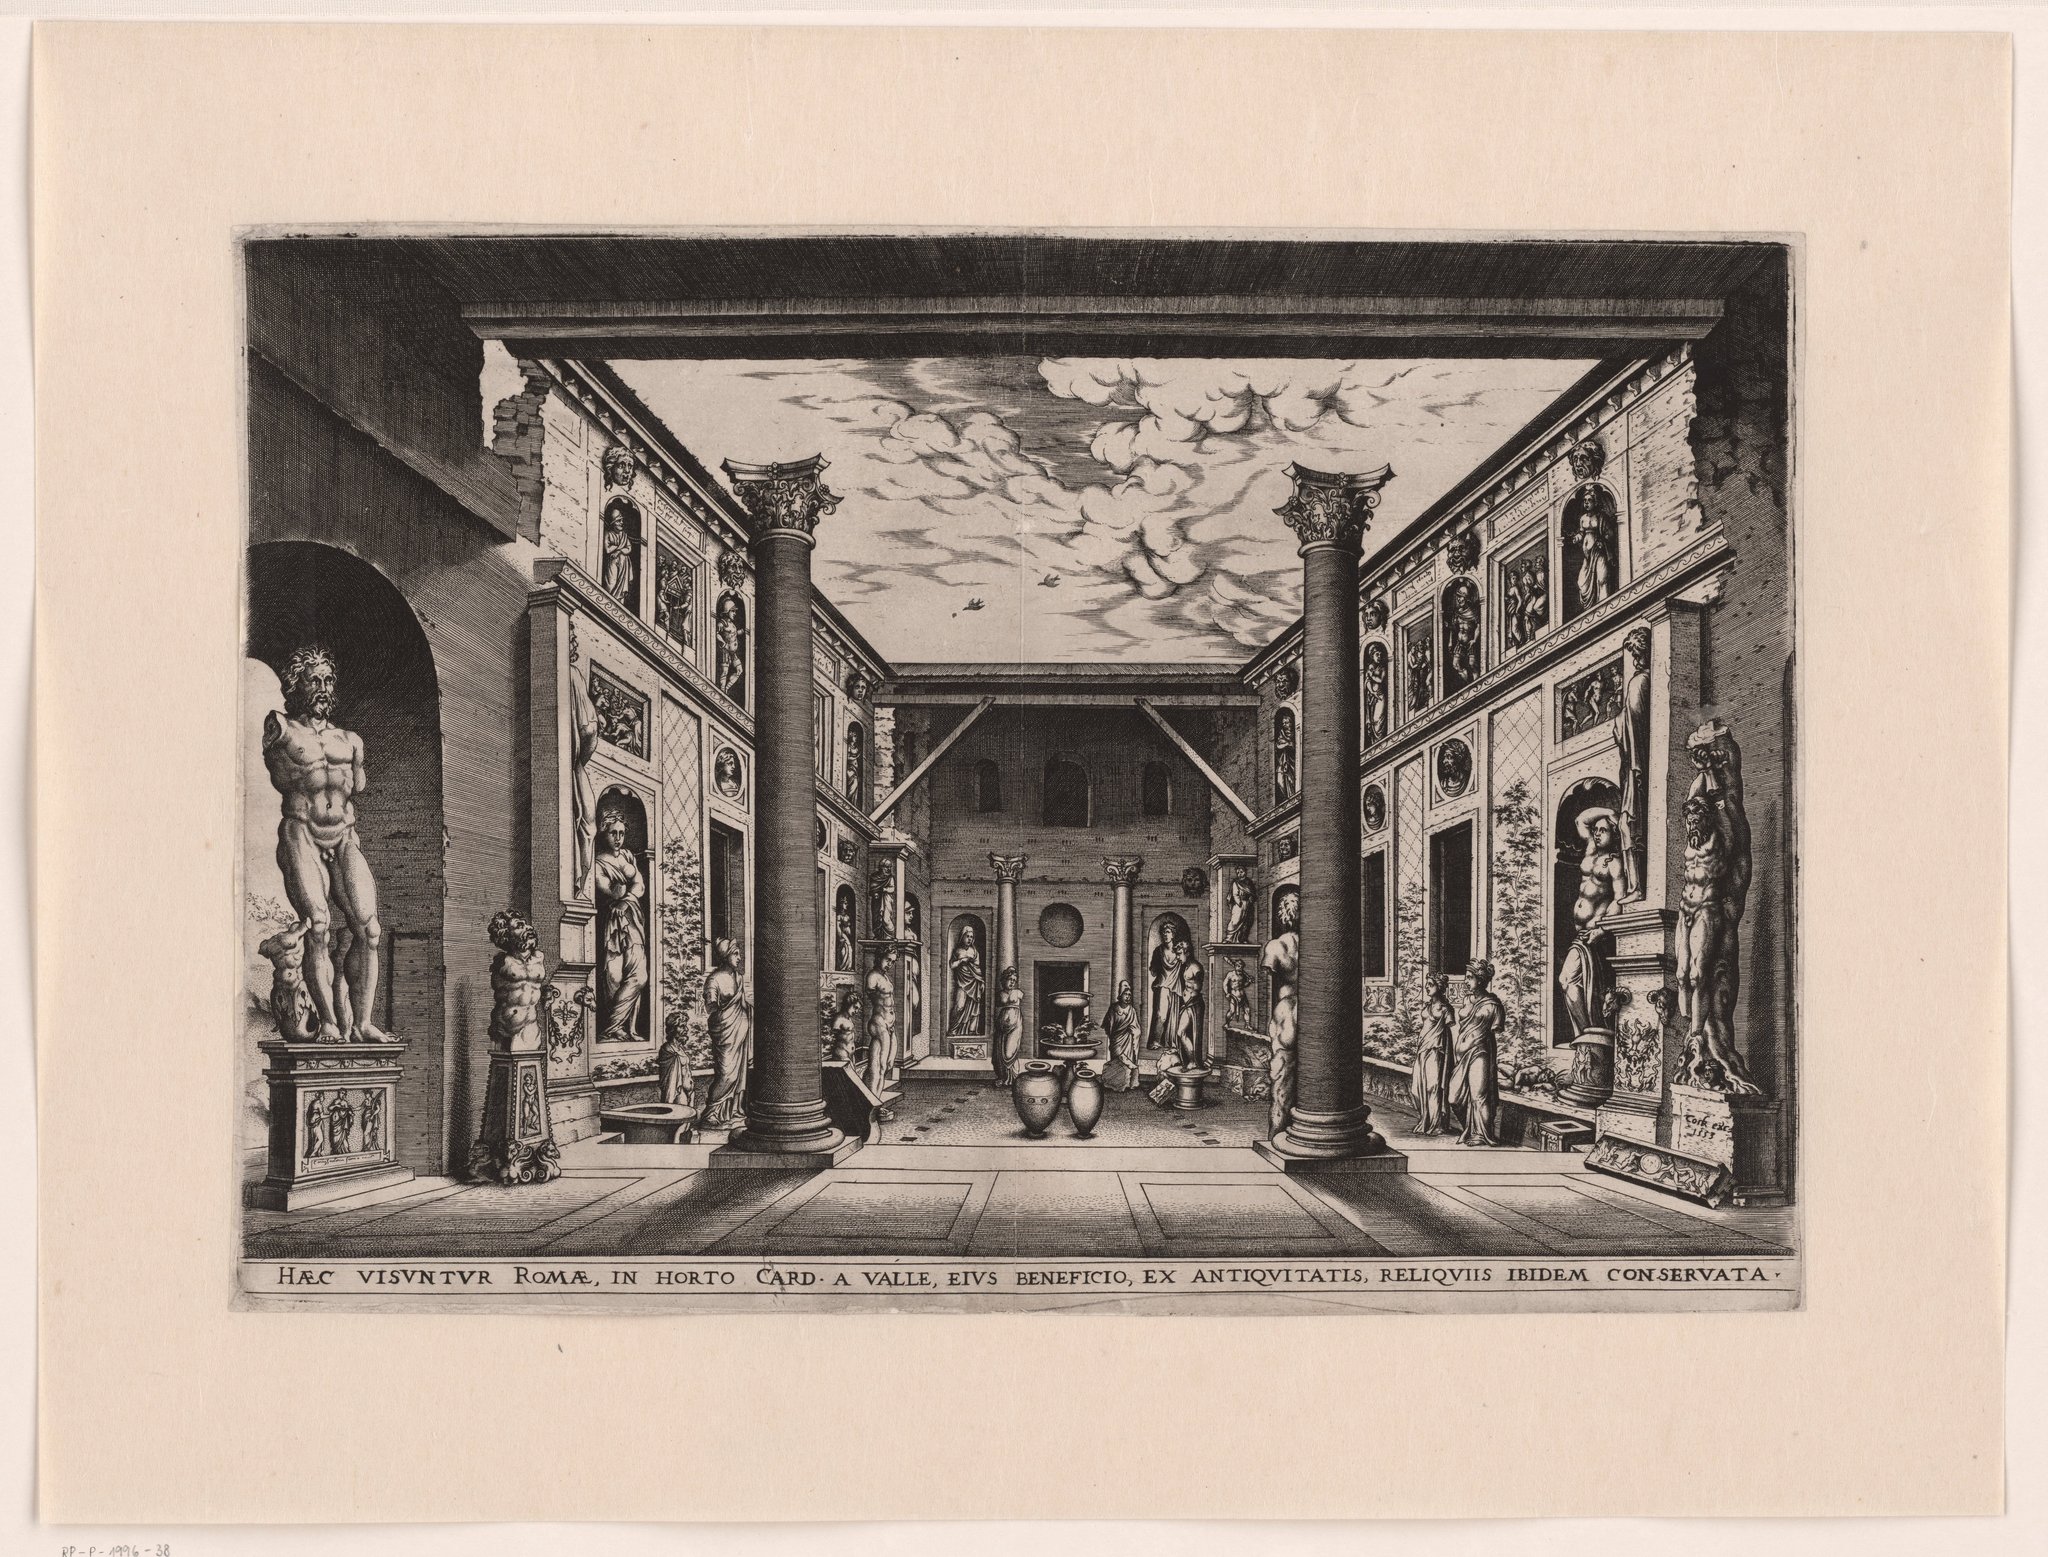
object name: print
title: Beeldentuin in Palazzo Valle, Capranica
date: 1553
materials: paper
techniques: engraving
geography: southern netherlands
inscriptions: inscription: ‘In marge onderaan: HAEC VISVNTVT ROMAE, IN HORTO CARD. A VALLE, EIUS BENEFICIO, EX ANTIQUITATIS, RELIQUIIS IBIDEM CONSERVATA.’, signature and date: ‘r.o. op sokkel: "Cock exc. 1553"’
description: Beeldentuin in Palazzo Valle, Capranica. Binnenplaats van het paleis met twee Corintische zuilen op de voorgrond. Antieke sculpturen, vrijstaand en in nissen.